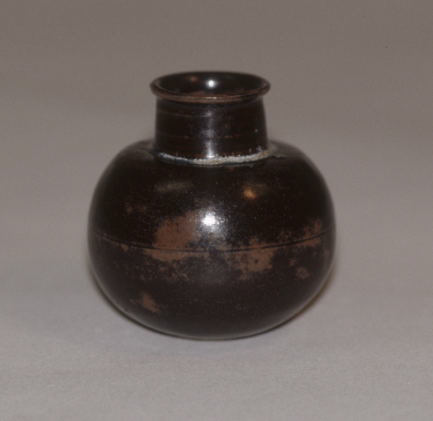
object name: tea jar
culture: japanese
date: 1650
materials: clay, glaze